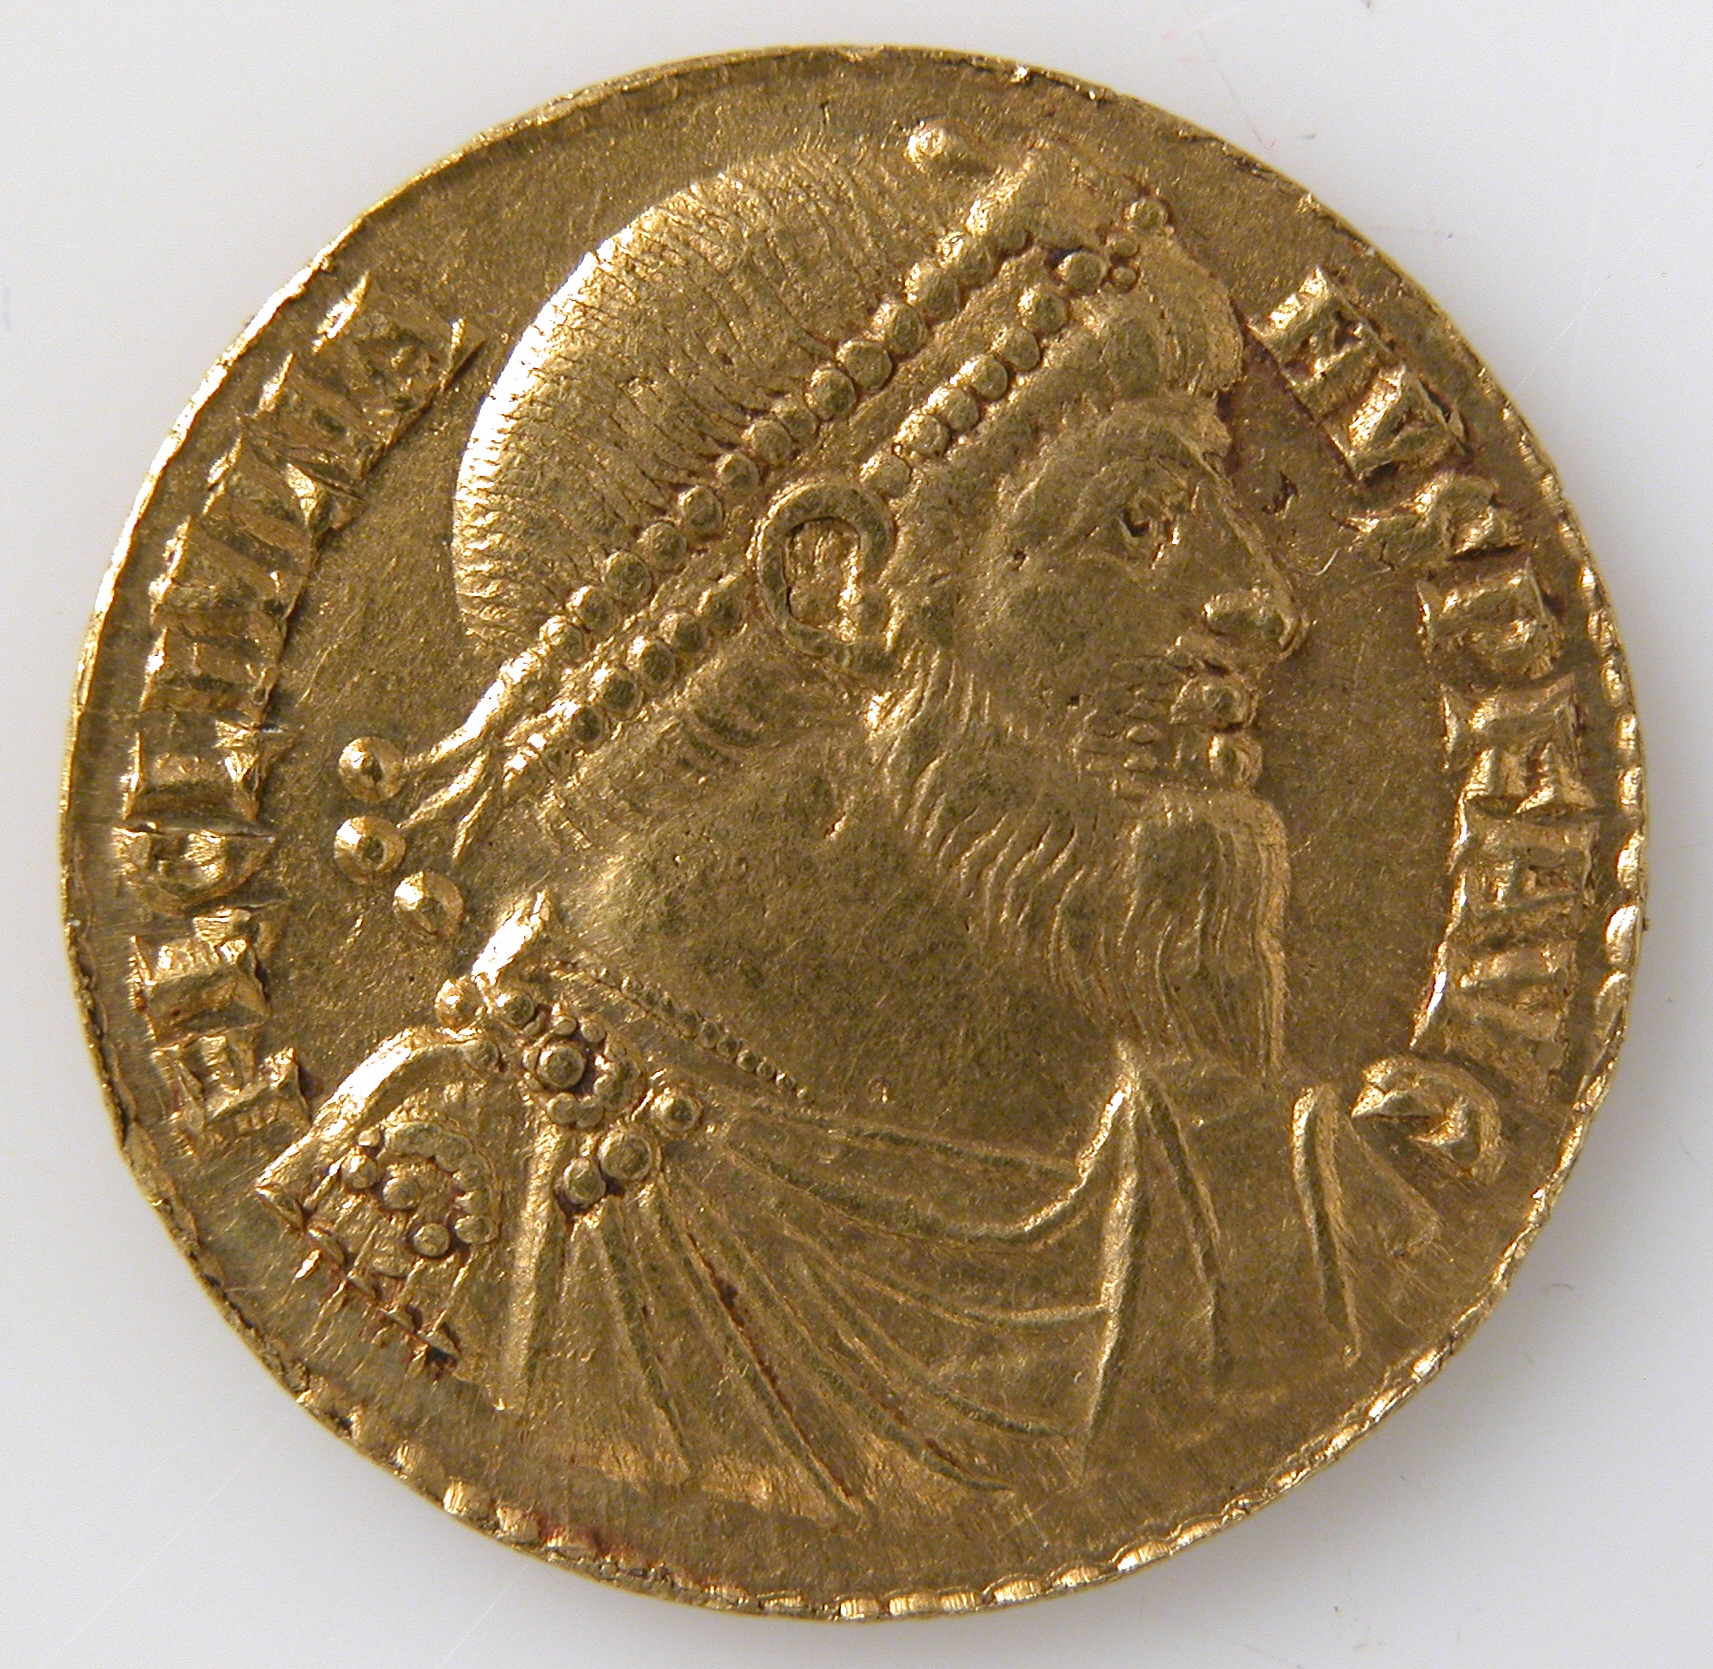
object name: solidus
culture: byzantine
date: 381-383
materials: gold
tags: emperors,men